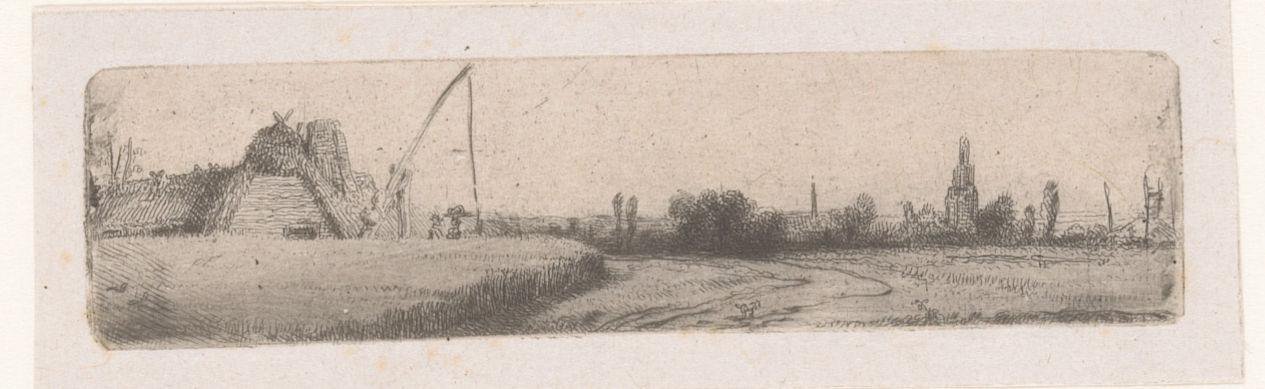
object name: print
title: Tarweveld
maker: jean pierre norblin de la gourdaine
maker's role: print maker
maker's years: 1745-1830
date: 1780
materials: paper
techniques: etching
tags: plants and herbs: wheat, farm or solitary house in landscape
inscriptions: collector's mark: Lugt 2228